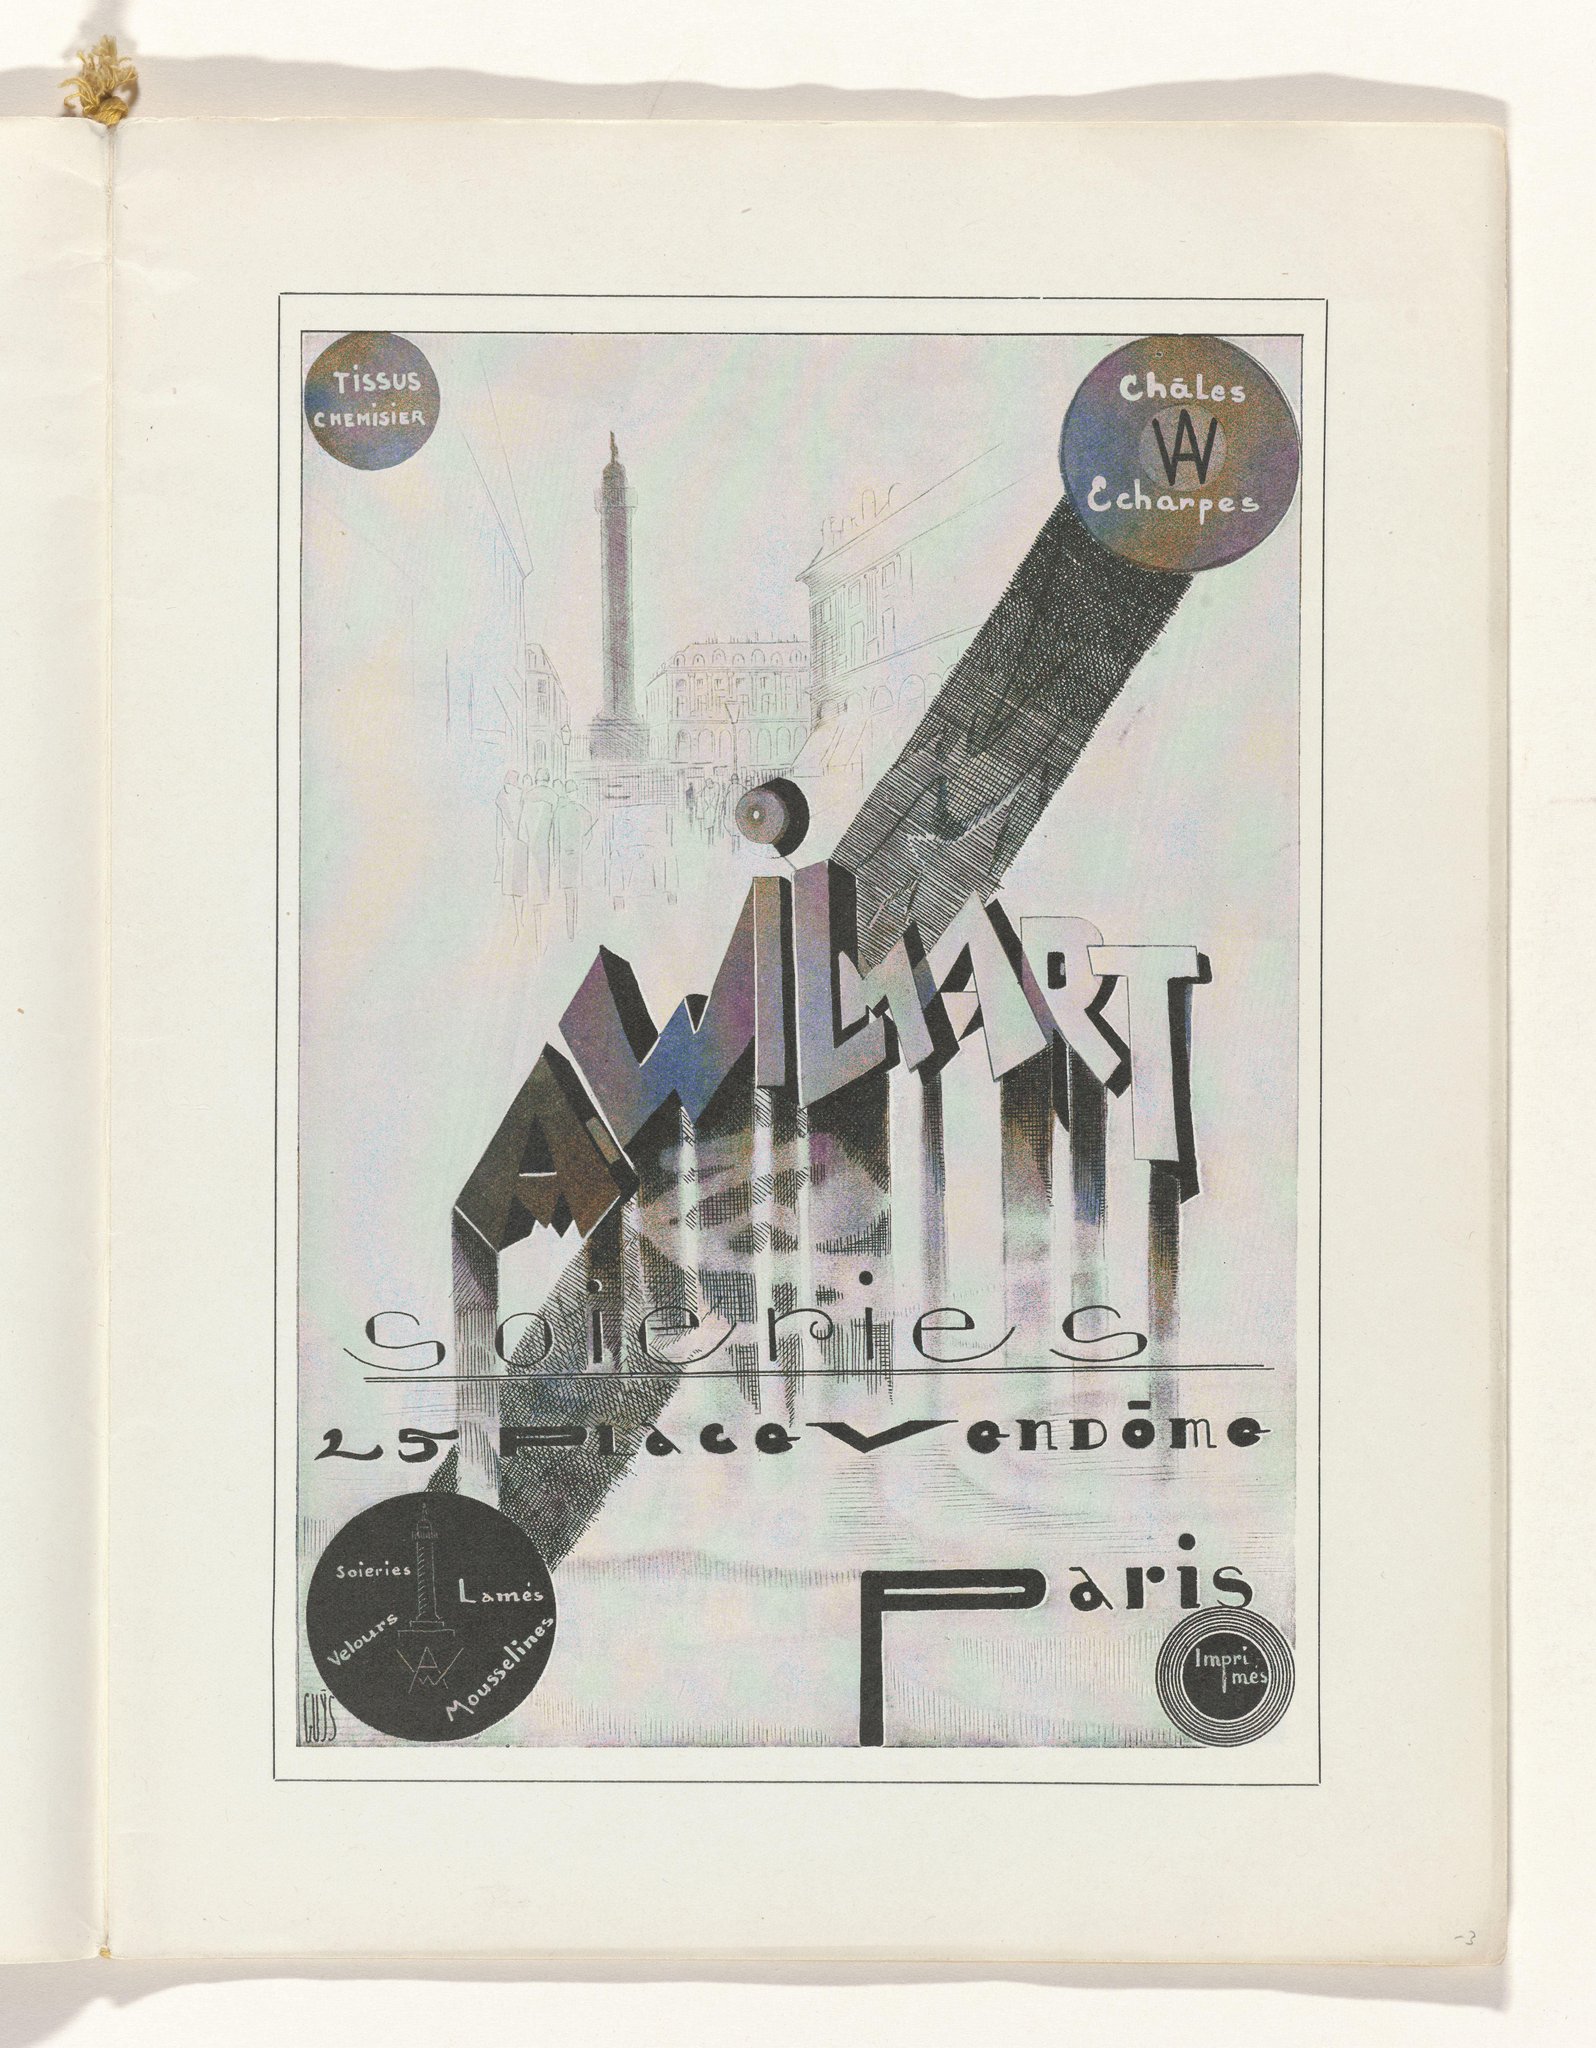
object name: fashion print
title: Art - Goût - Beauté, Feuillets de l' élégance féminine, Mars 1932, No. 139, 12e Année, p. 3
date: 1932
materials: paper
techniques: photography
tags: fashion plates, street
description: Advertentie voor stoffen en sjaals van A. Wilmart. Pagina uit het modetijdschrift Art-Goût-Beauté (1920-1933).